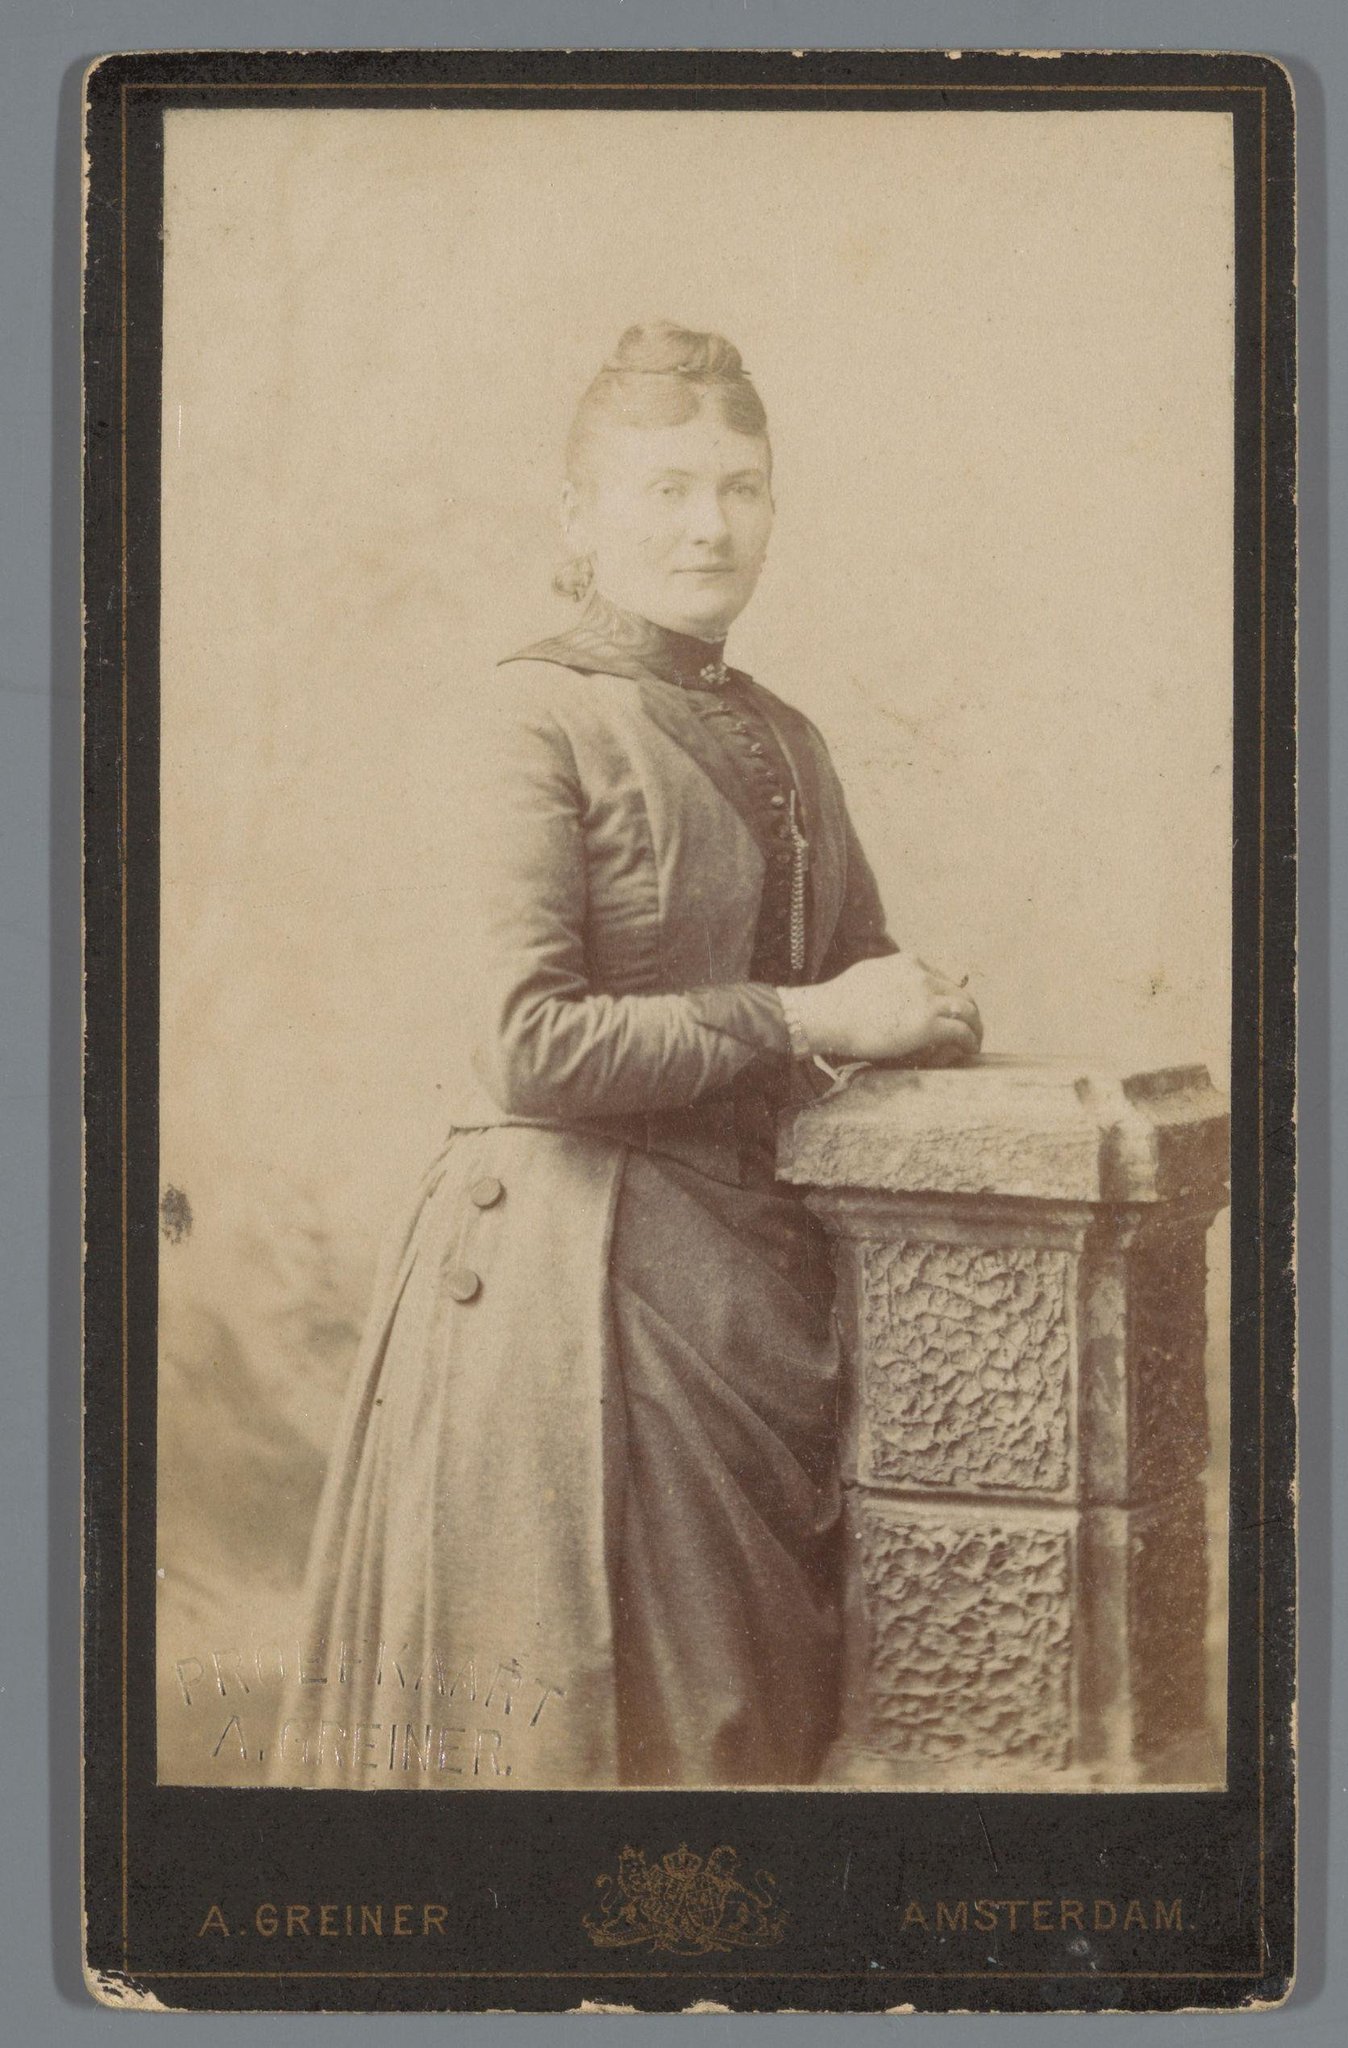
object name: photograph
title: Portret van een onbekende vrouw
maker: albert greiner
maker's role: fotograaf, fotostudio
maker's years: 1833-1890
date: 1874-1887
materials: cardboard, paper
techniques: albumen print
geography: amsterdam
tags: historical persons - bb - woman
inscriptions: inscription: ‘ALBERT GREINER/ KON. NED. HOF-PHOTOGRAAF/ AMSTERDAM/ NIEUWENDIJK 89./ Specialiteit in Vergrootingen.’